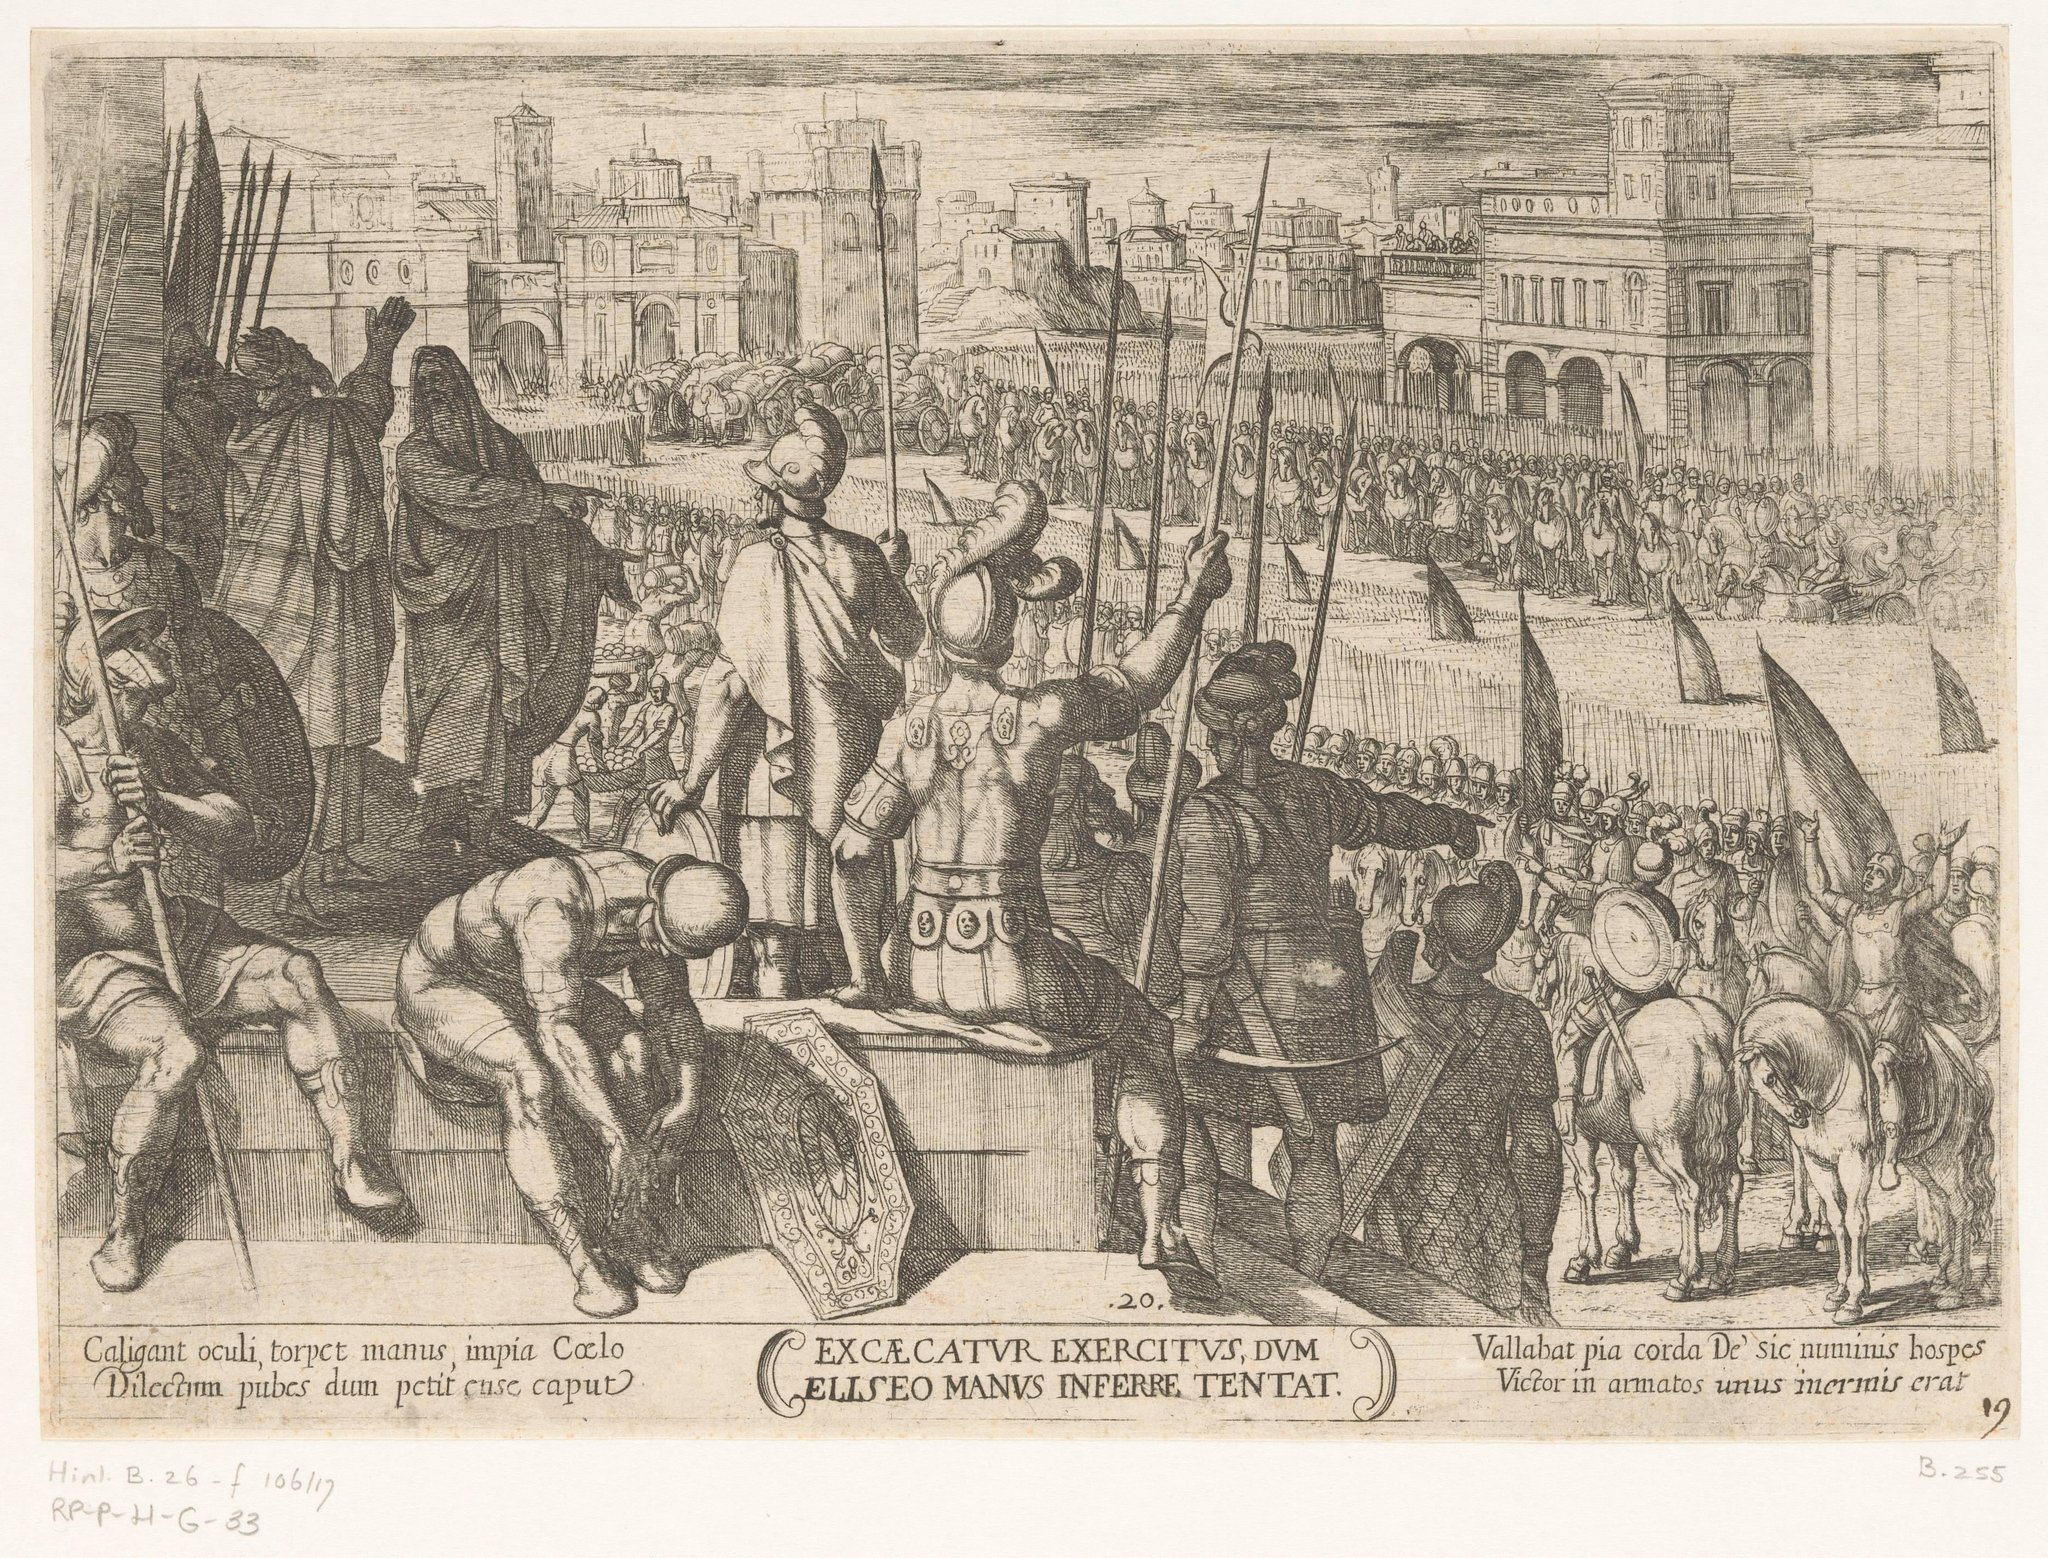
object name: print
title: Excae catur exercitus, dum eliseo manus inferre tentat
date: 1613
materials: paper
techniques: etching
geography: italy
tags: elisha leads the blind syrians into the city of samaria, in samaria elisha restores the sight of the syrians and causes the king of israel to feed them, and to let them return peacefully to syria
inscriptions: number: ‘19’, collector's mark: ‘Hinloopen’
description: Elisa brengt het geblindeerde Syrische leger bij de koning van Israël. De koning van Israël staat op een verhoging en kijkt uit over de menigte soldaten op een groot plein. Titel en onderschrift in het Latijn in de ondermarge.